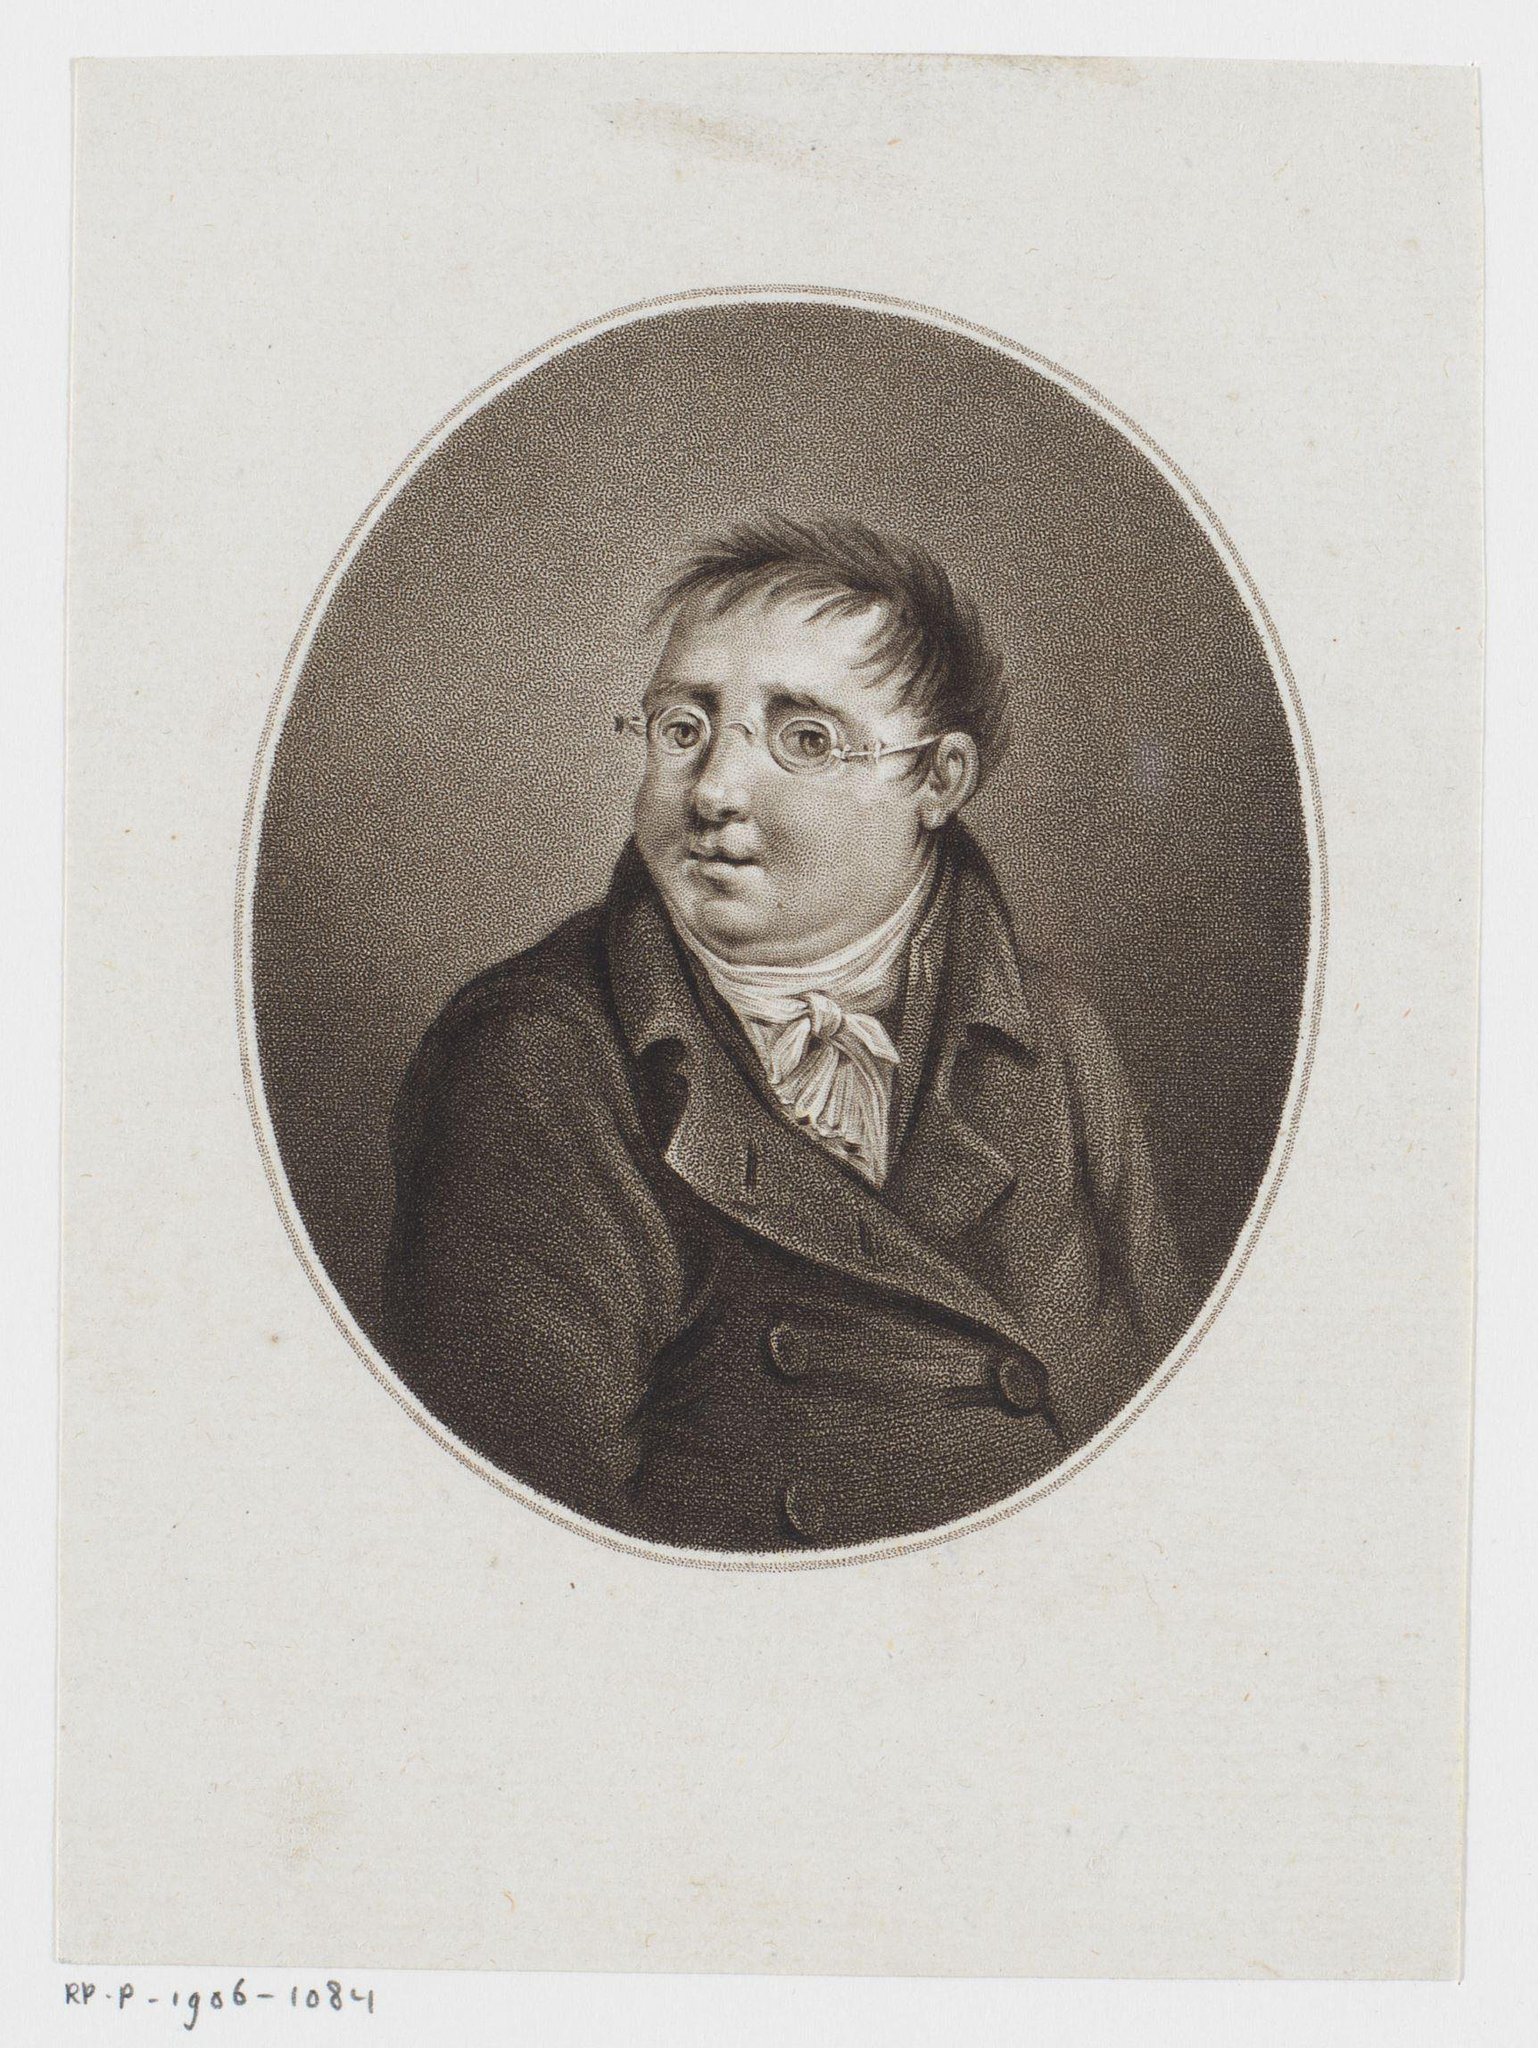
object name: print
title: Portret van Jan Frederik Helmers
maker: willem van senus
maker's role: painter, print maker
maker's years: 1773-1851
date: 1783-1851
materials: paper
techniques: engraving, etching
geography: netherlands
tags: amsterdam, jan frederik helmers, eyeglasses, spectacles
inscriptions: collector's mark: Lugt 2228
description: Portret van de letterkundige Jan Frederik Helmers.